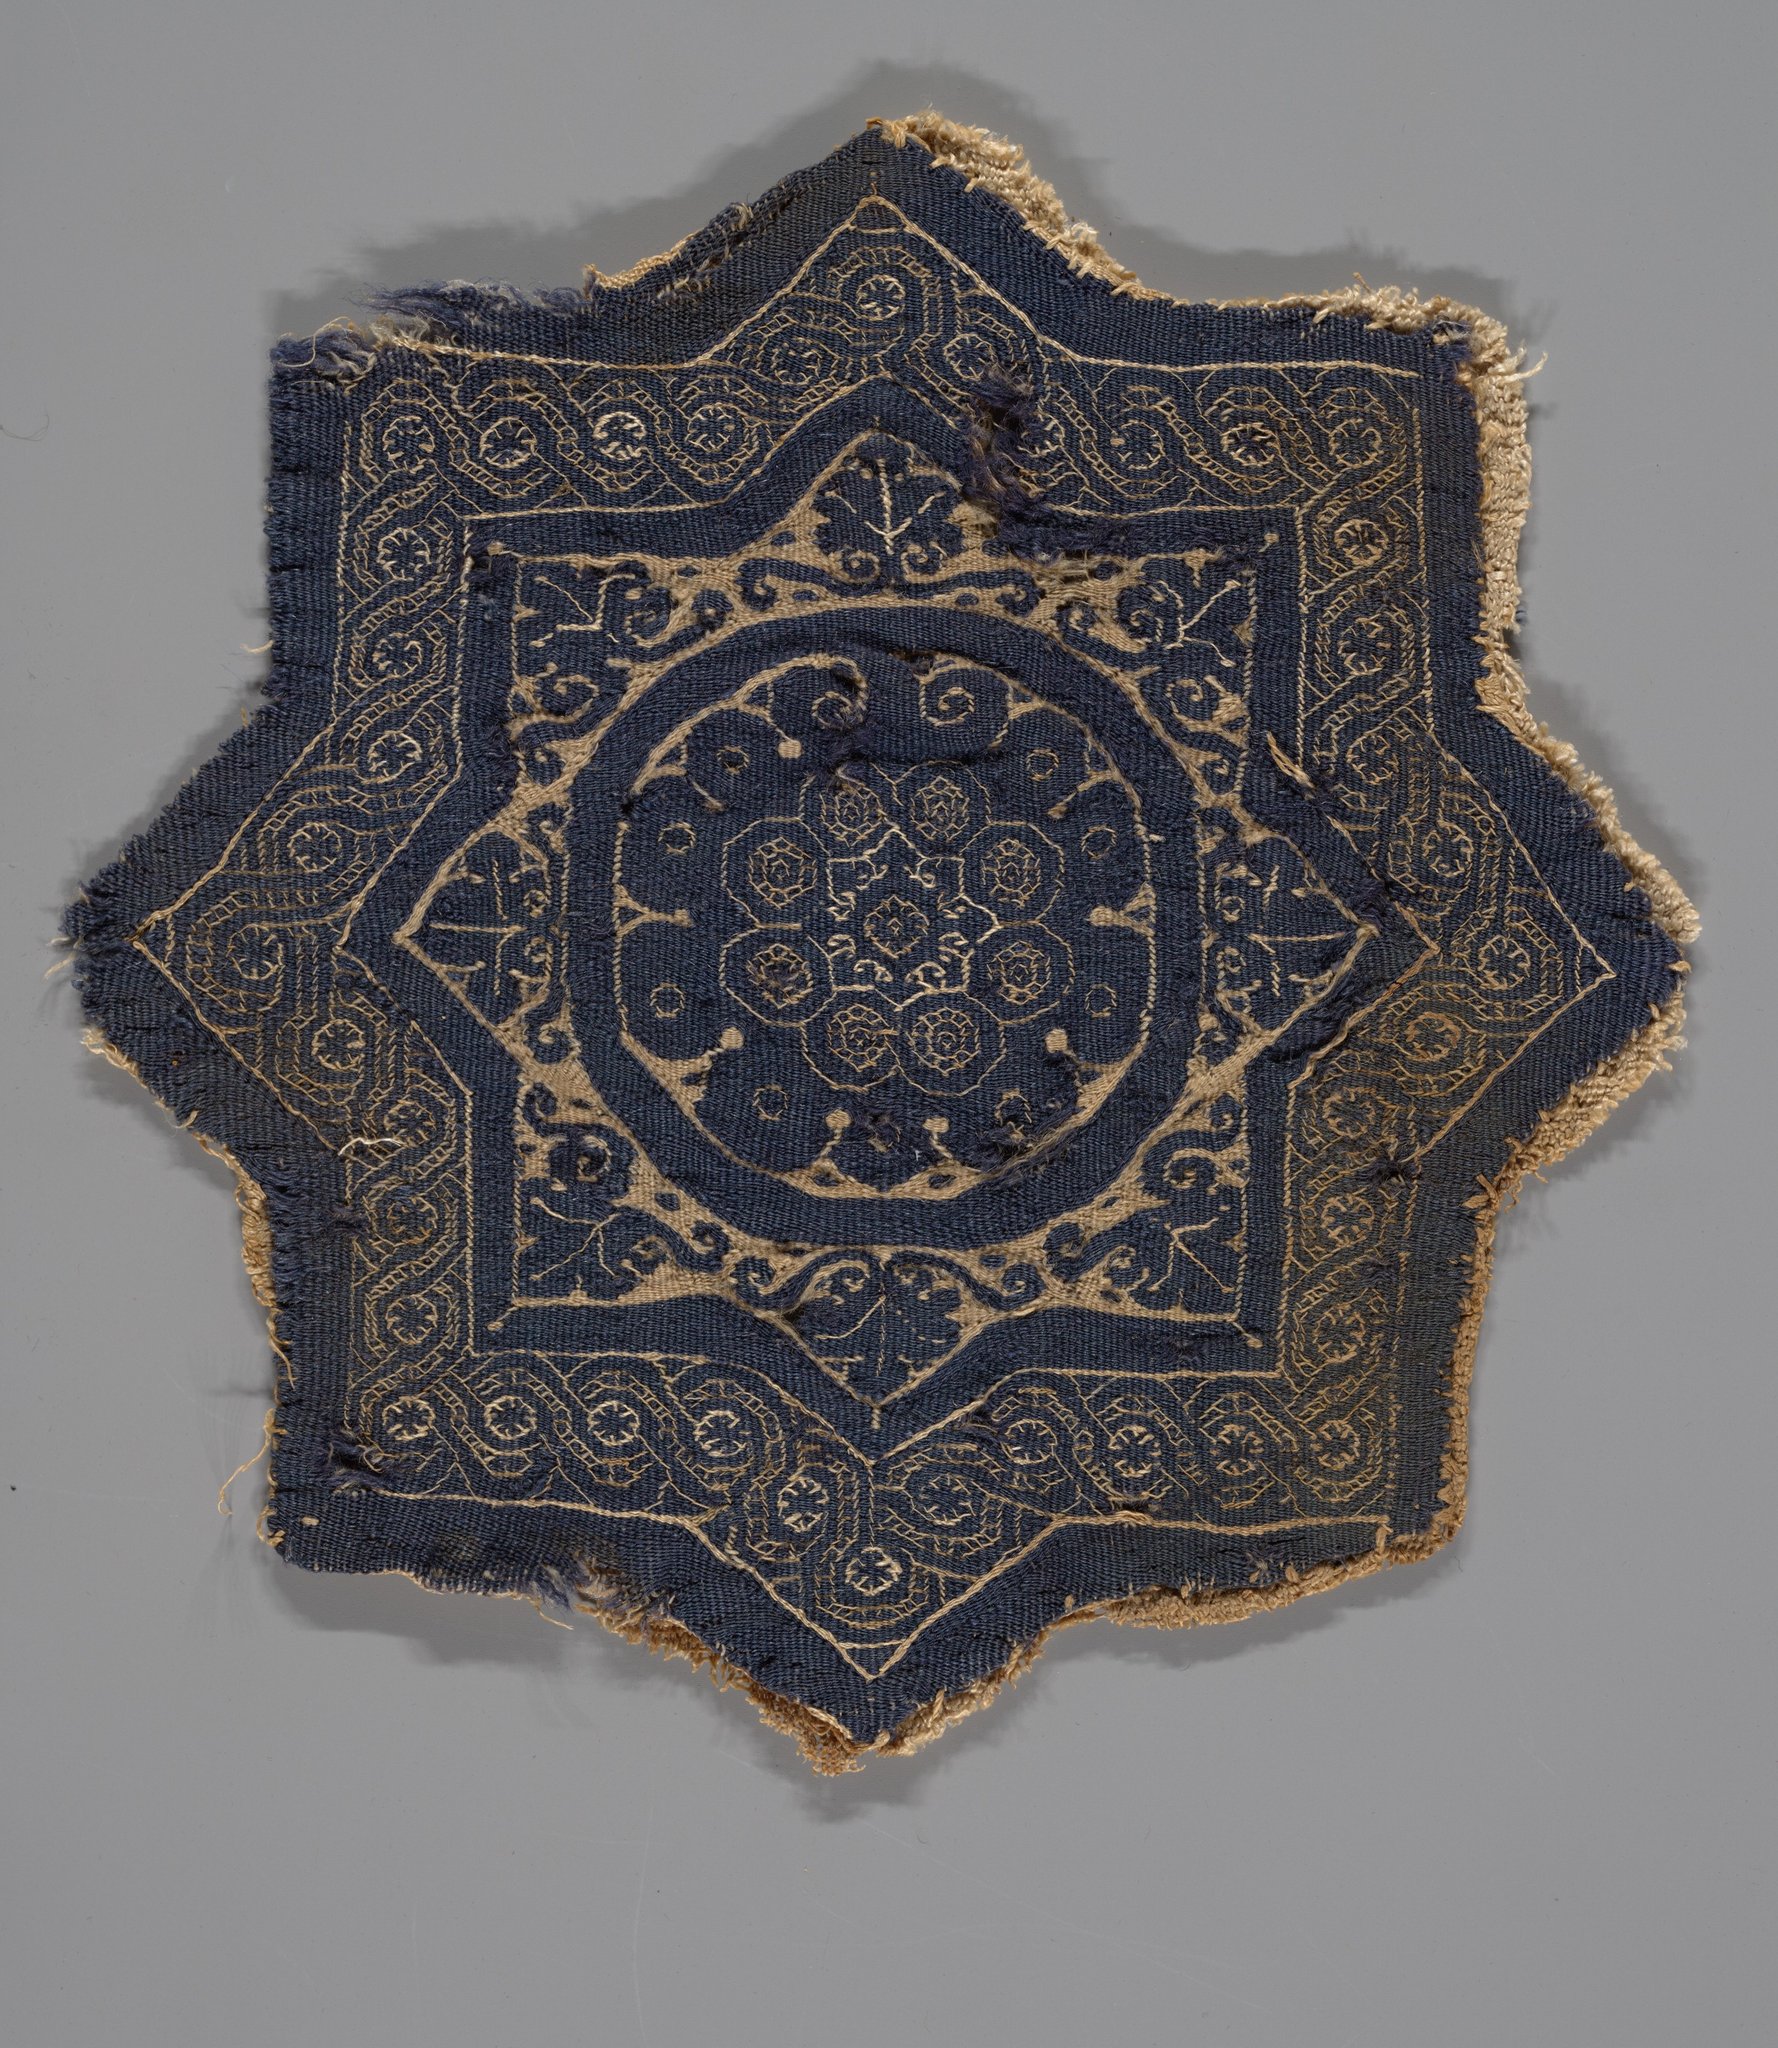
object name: textile fragment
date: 201-400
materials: linen, wool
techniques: weave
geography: egypt